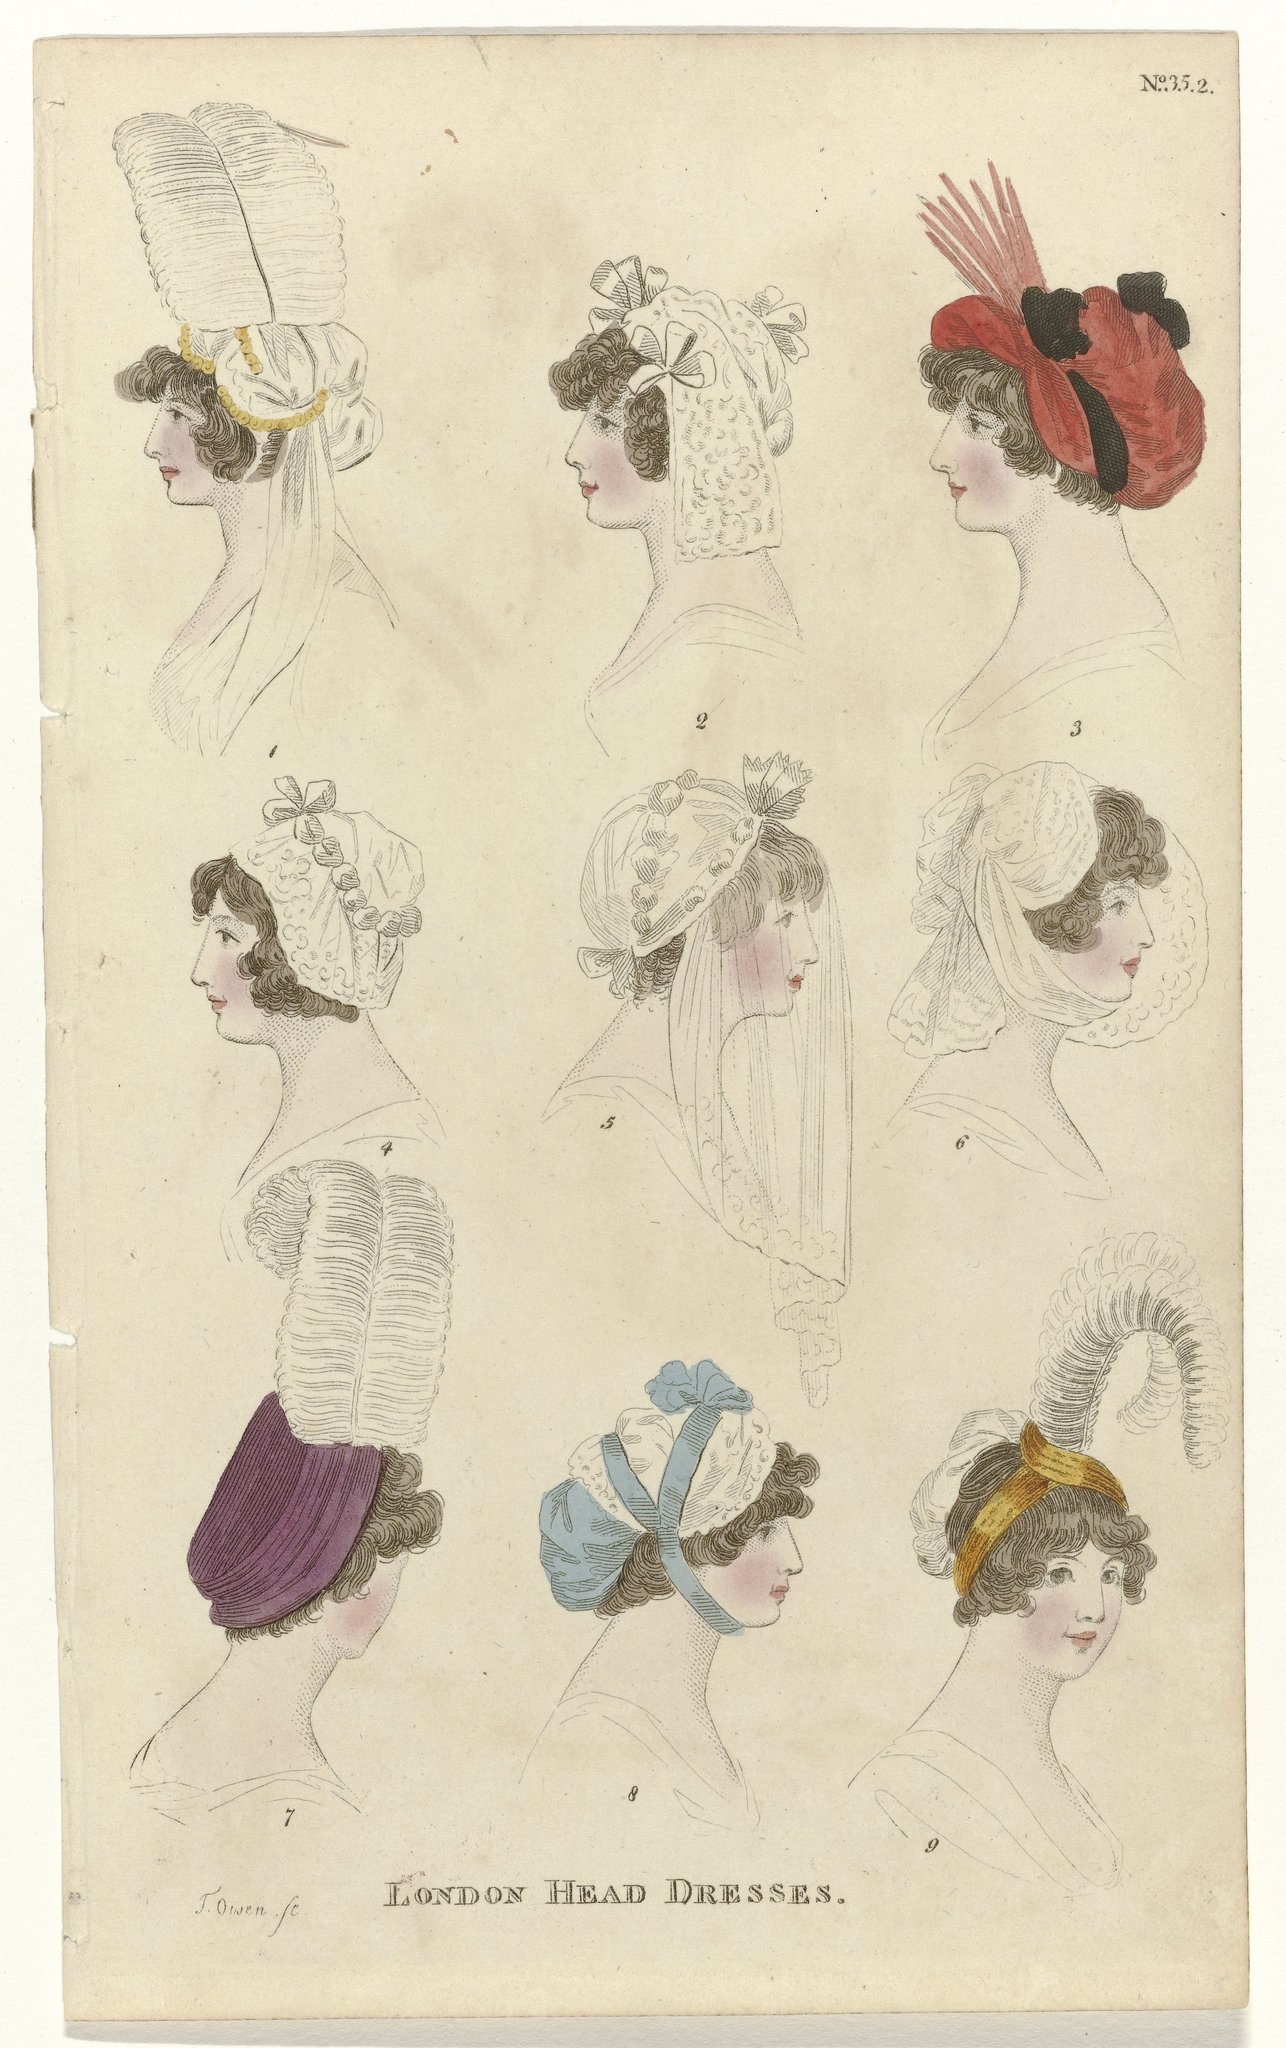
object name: fashion print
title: Magazine of Female Fashion of London and Paris, 1800, No. 35.2: London Head Dresses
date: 1800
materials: paper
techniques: etching, hand coloring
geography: london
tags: head-gear (+ women's clothes), styles of hairdress - aa - ~ women, fashion plates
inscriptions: title: ‘London Head Dresses.’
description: Negen vrouwenhoofden met verschillende hoofddeksels en kapsels uit Londen in 1800. Prent uit het modetijdschrift Magazine of Female Fashion of London and Paris (1798-1806).